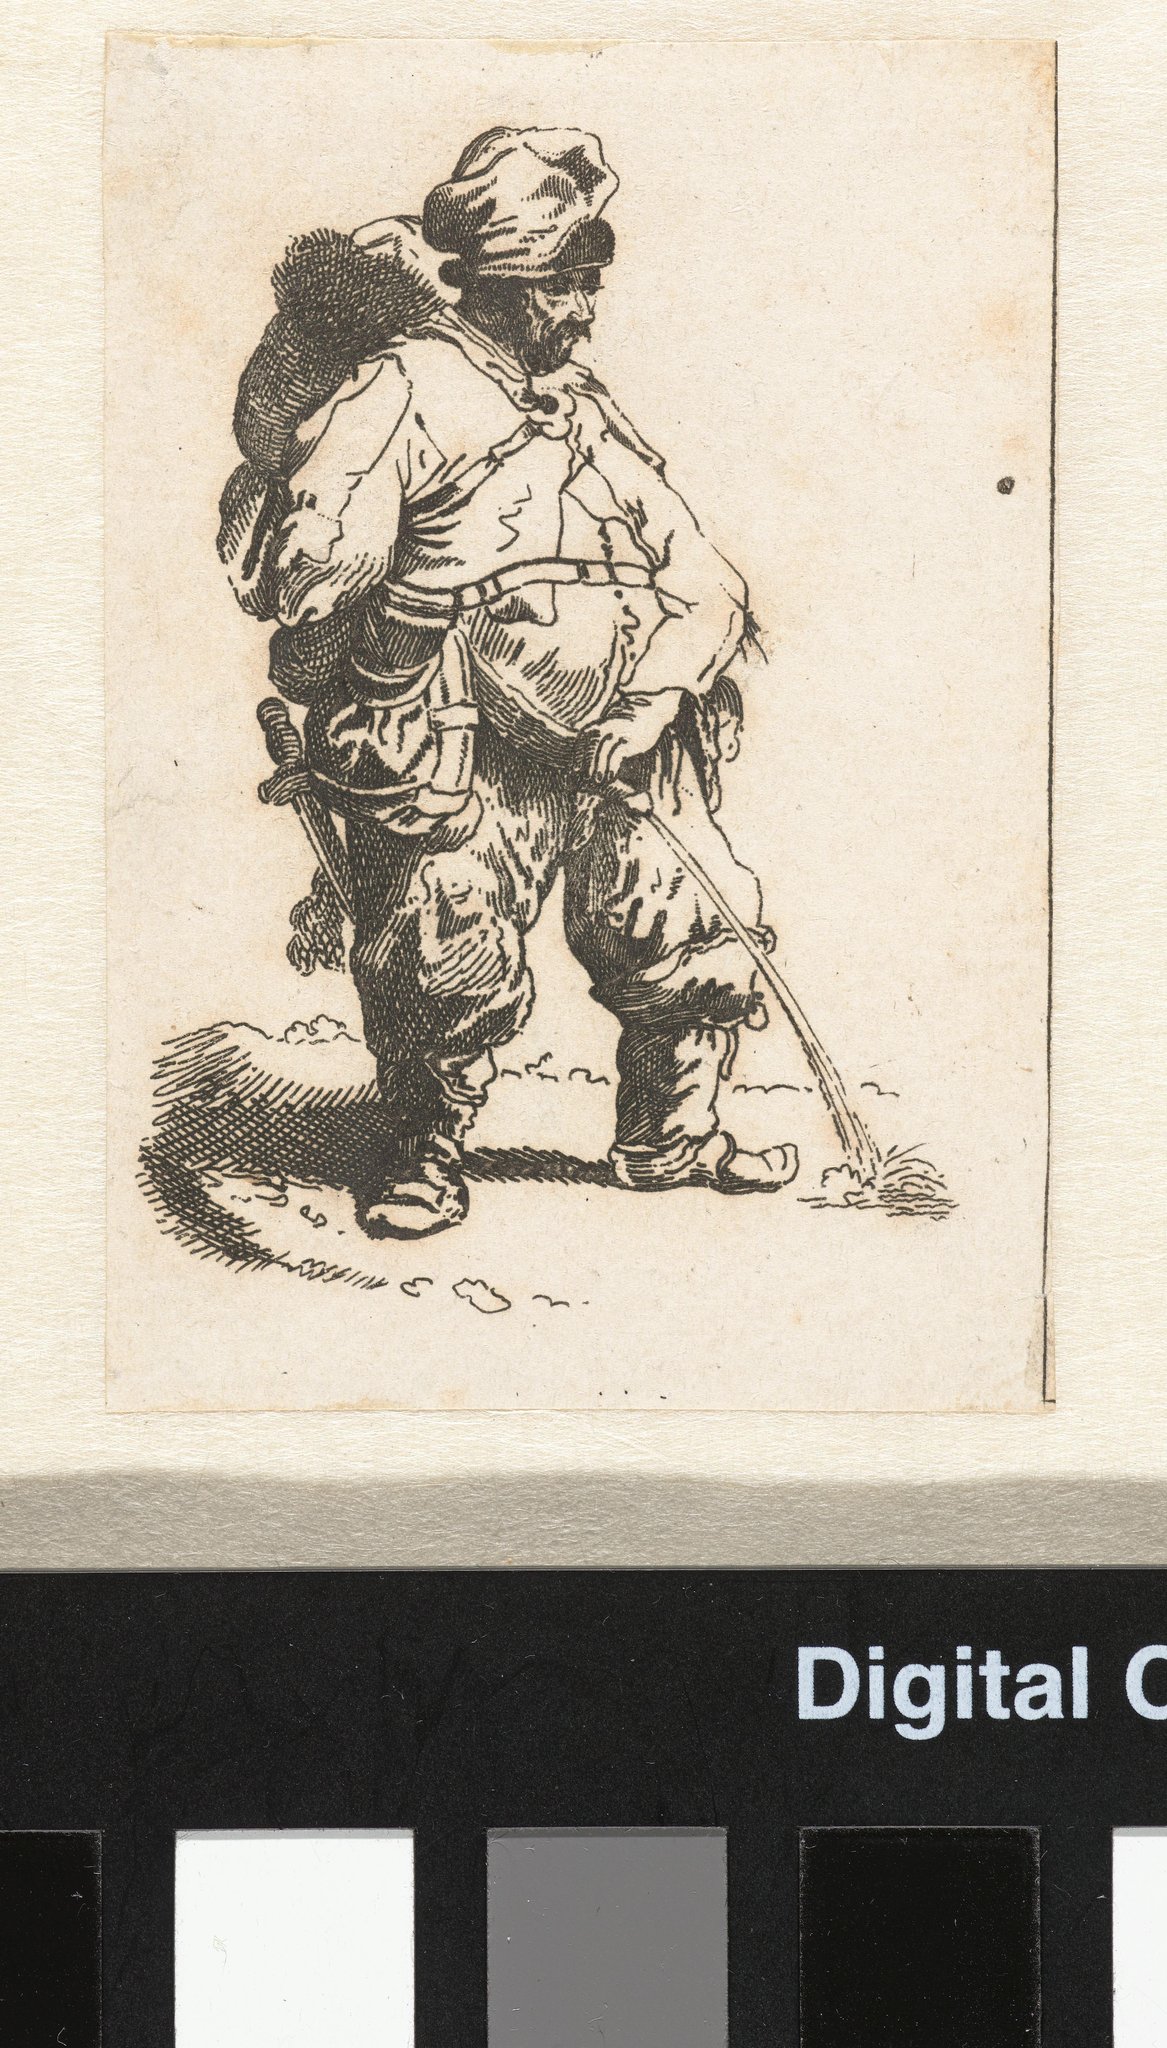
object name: print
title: A man making water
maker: Anonymous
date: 1630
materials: paper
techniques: etching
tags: urination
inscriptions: collector's mark: Lugt 2760, collector's mark: Lugt 2228